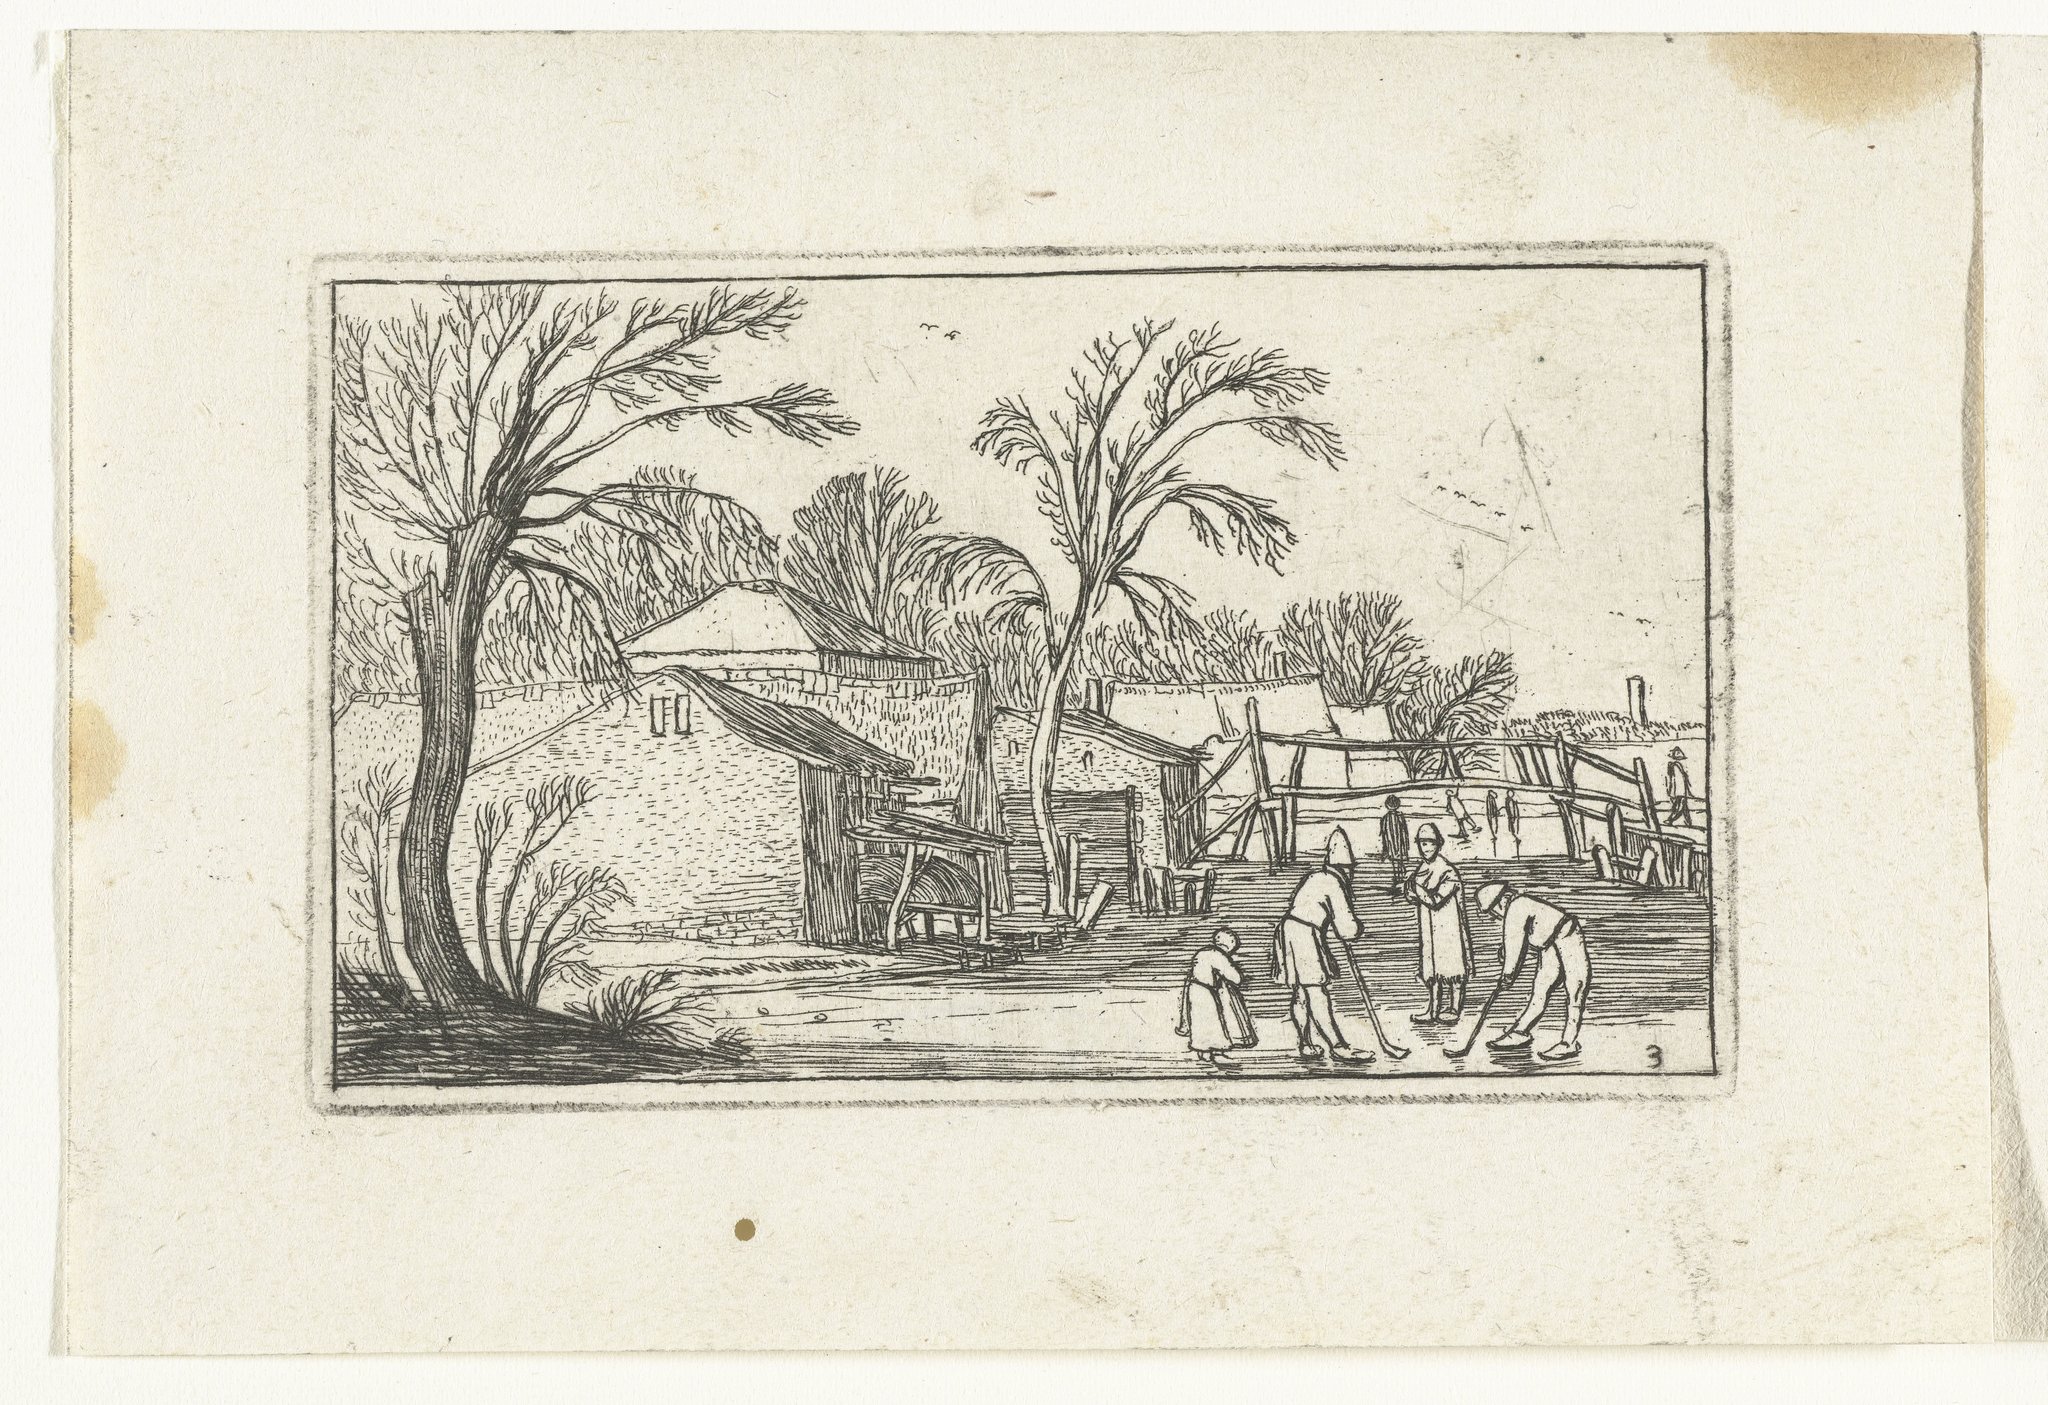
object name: print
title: Landschappen naar Esaias van de Velde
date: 1610-1617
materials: paper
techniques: etching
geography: haarlem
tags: skates (winter sports), farm or solitary house in landscape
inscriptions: collector's mark: Lugt 2228a